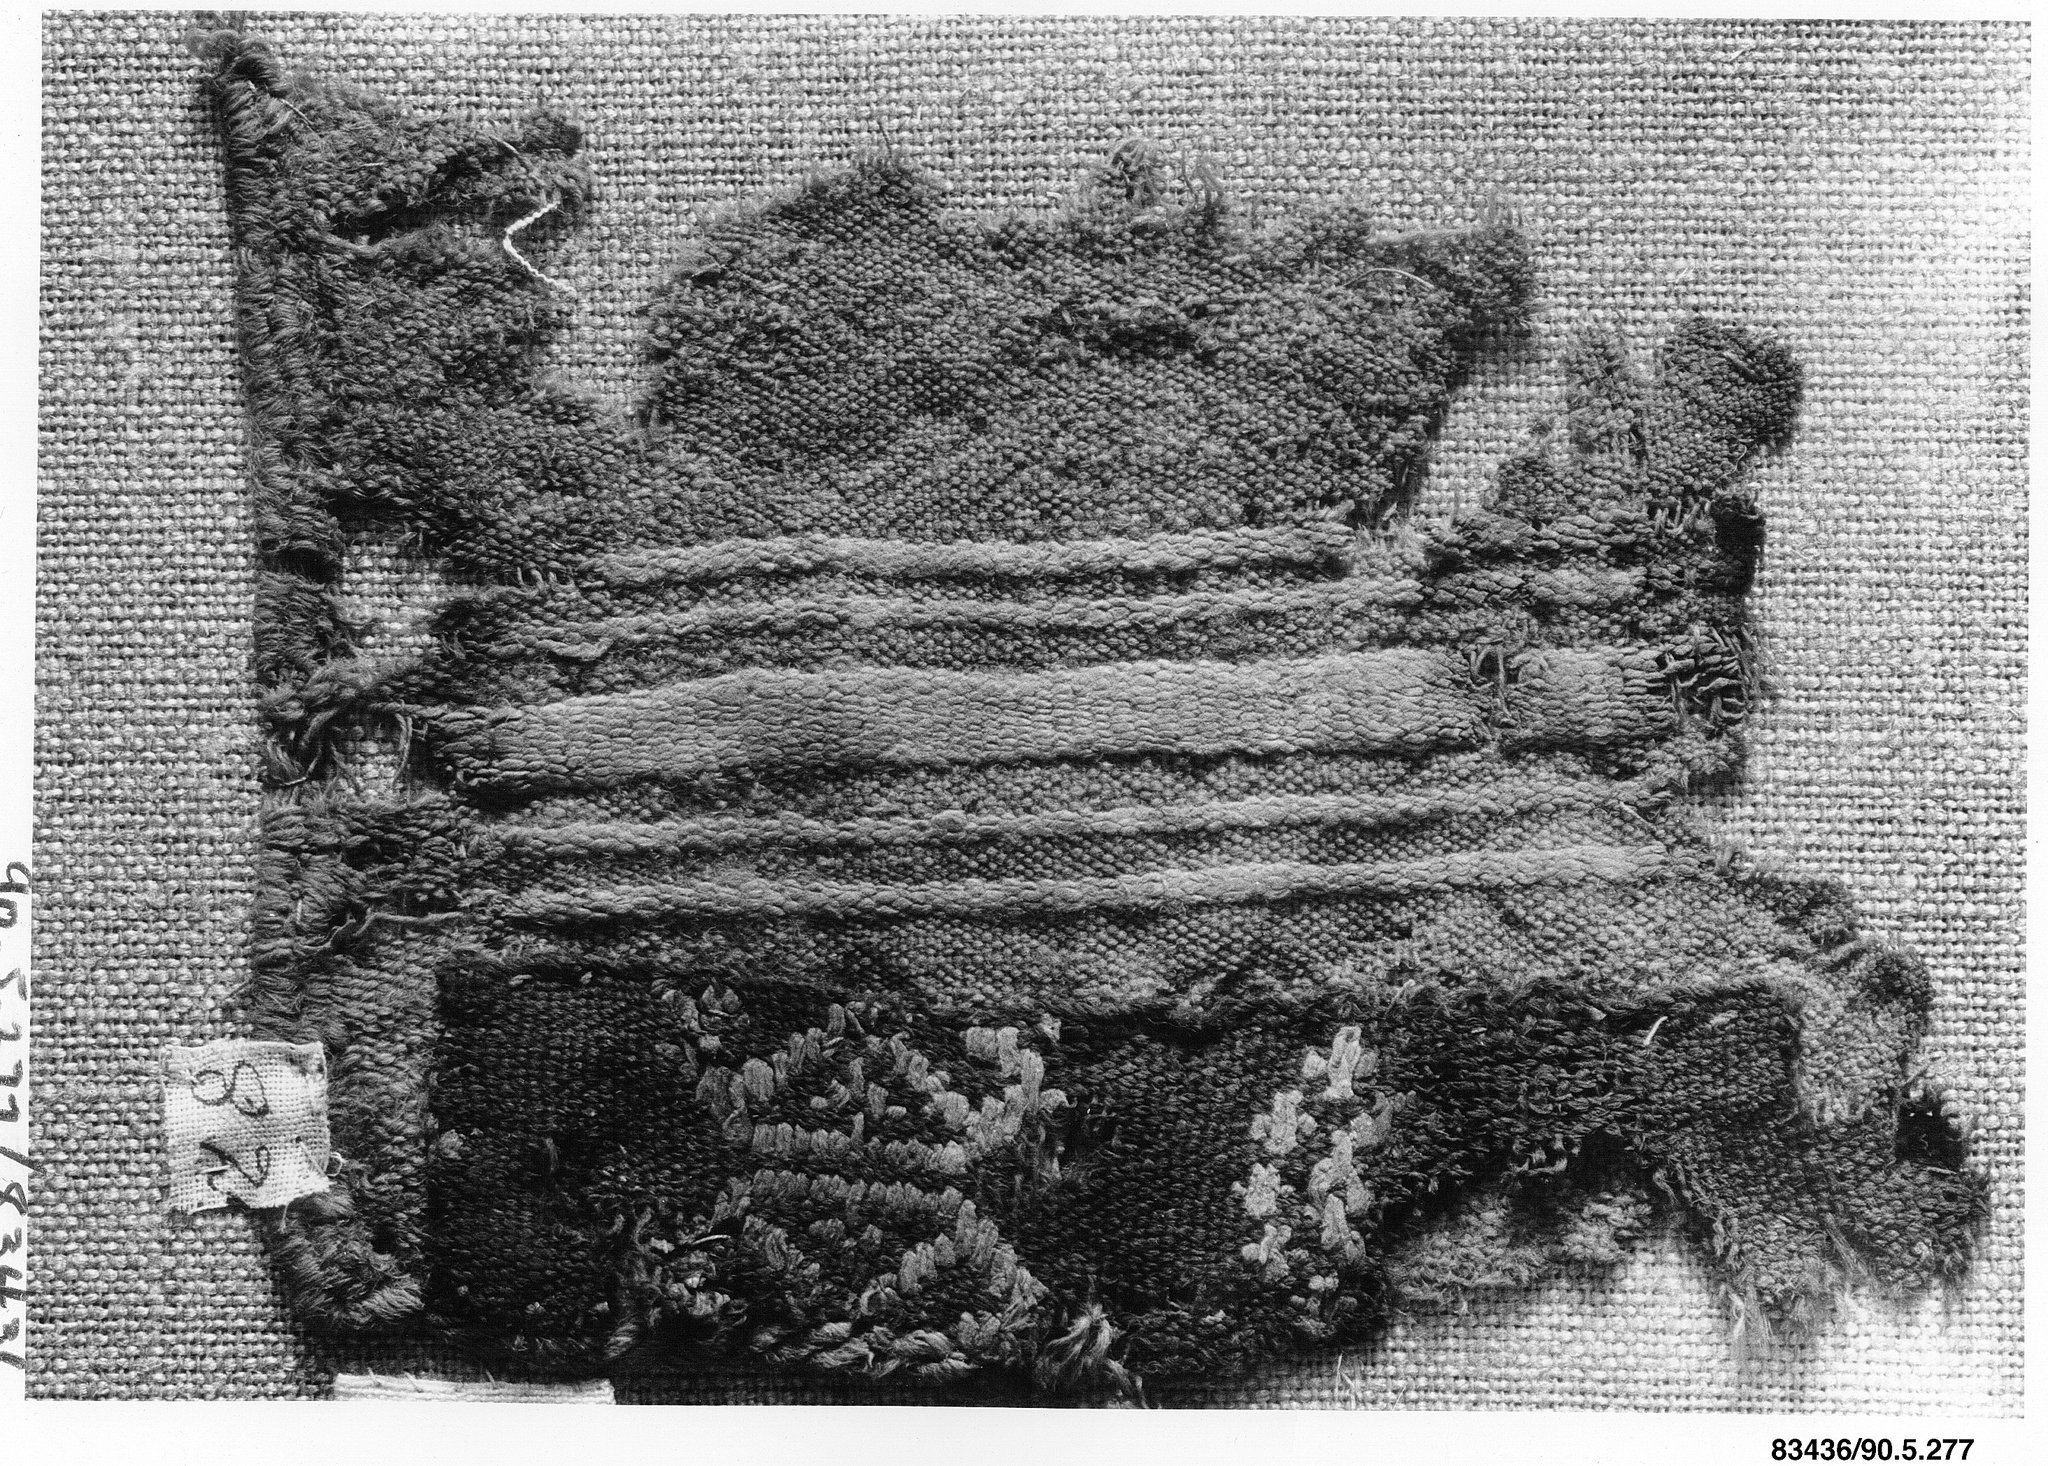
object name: textile fragment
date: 401-600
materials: linen, wool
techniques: weave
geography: egypt